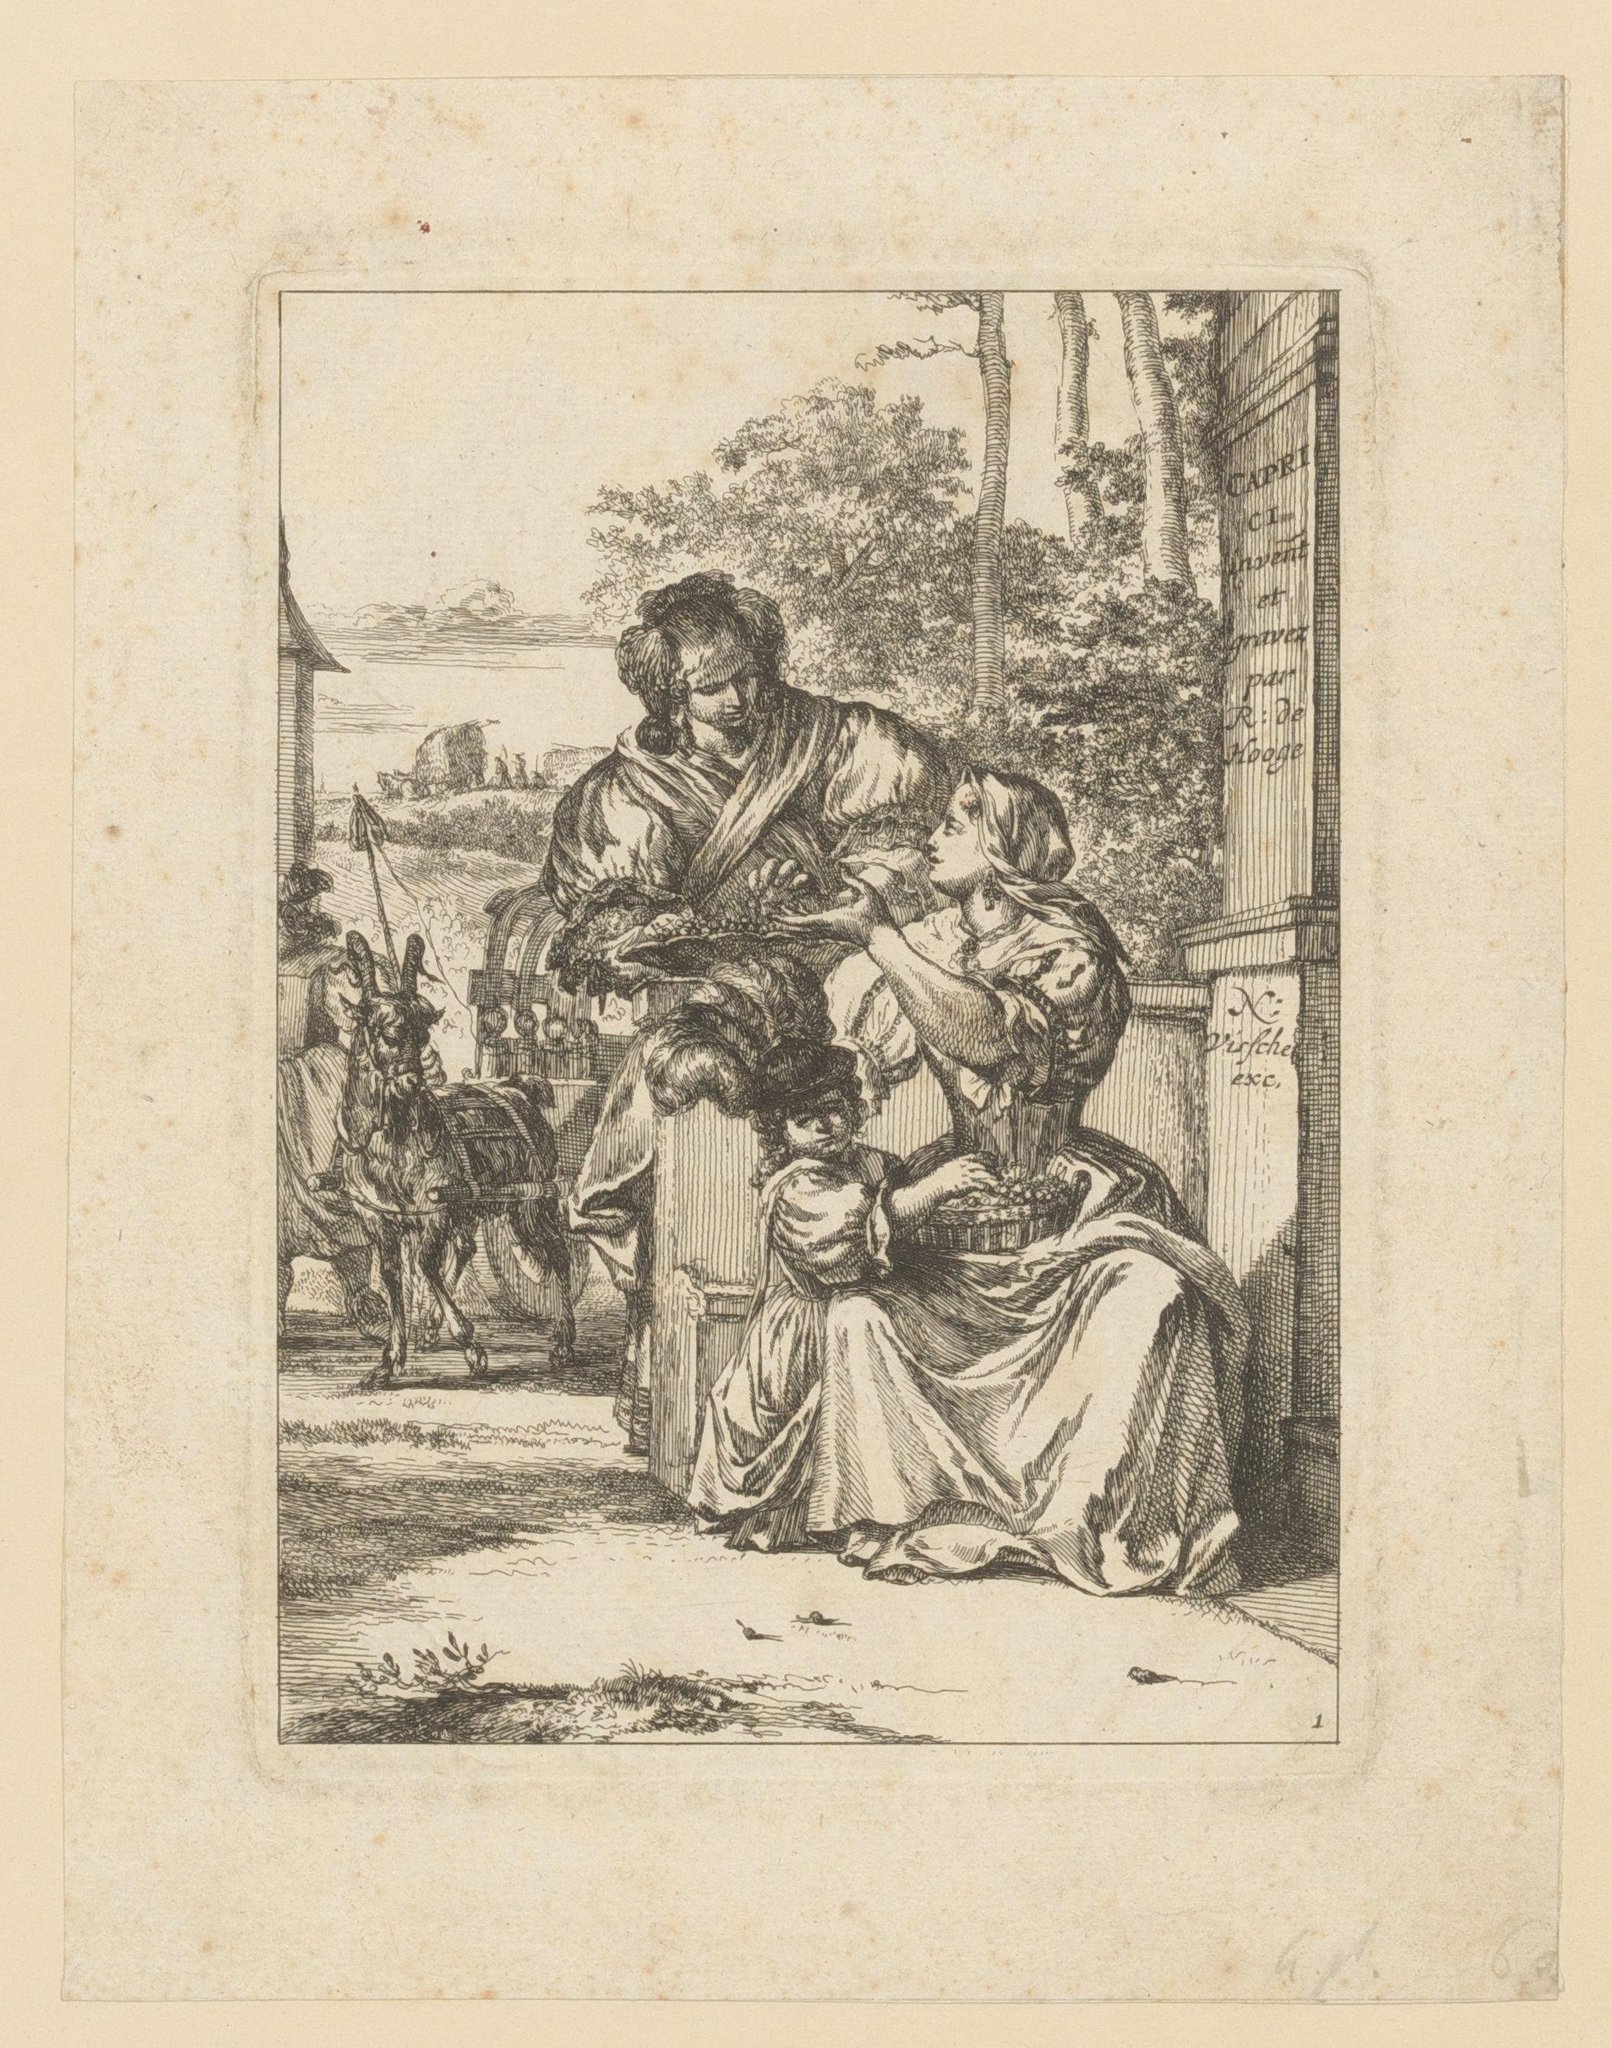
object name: titelprent, frontispice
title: Titelprent van de serie Capricci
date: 1662-1679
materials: paper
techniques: engraving, etching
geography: amsterdam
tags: goat, fruits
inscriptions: collector's mark: Lugt 1641, stamp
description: Een zittende vrouw met een mand kersen op haar schoot en een kind dat in de mand graait. De vrouw keert zich om naar een staande vrouw met een schaal met kersen. Op de achtergrond een bokkenwagen met kind. Rechts op zuil de titel van de serie en de namen van De Hooghe en Visscher. Rechtsonder genummerd: 1. Onderwerpsrubrieken binnen de Atlas Zeden en Gewoonten: Zeden en Gewoonten in Engeren Zin, De Kleeding, Kleederdrachten (tijdvakken), Lodewijk XIV (1650 – 1720). Het allonge tijdvak).